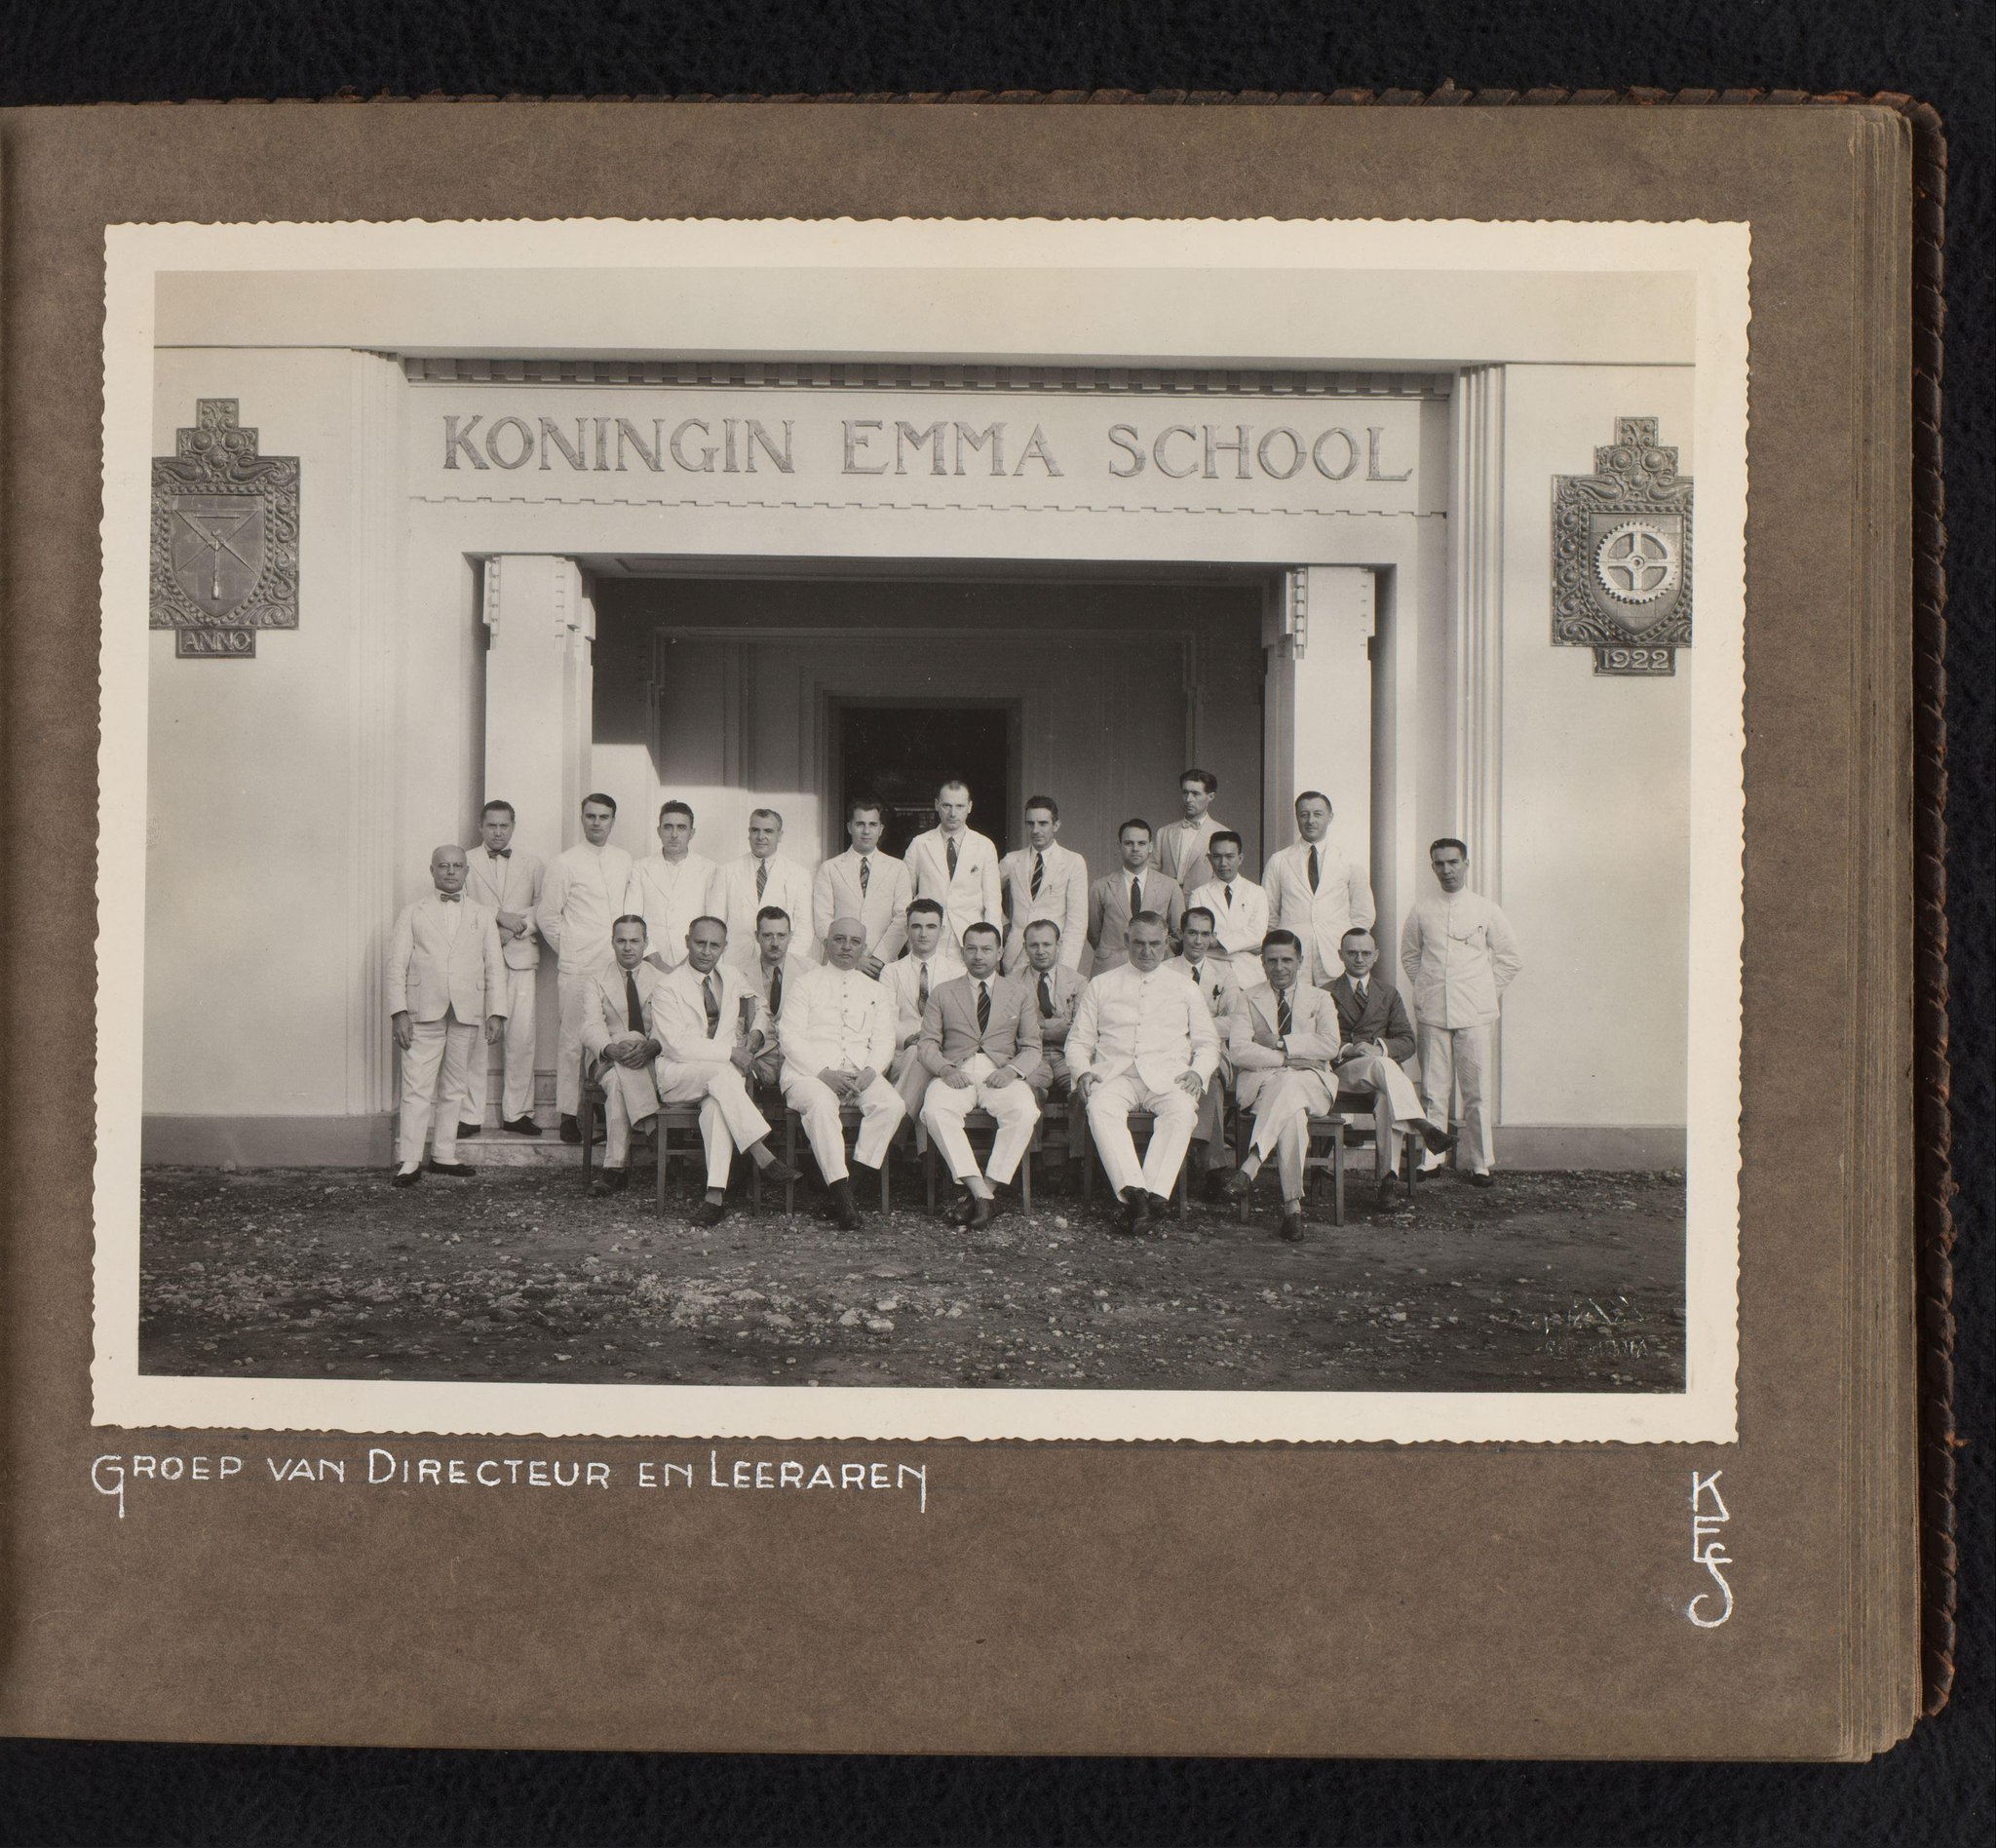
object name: photograph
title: Directeur en leraren van de Koningin Emma School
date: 1933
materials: photographic support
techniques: gelatin silver print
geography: surabaya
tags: vocational education, e.g.: junior technical school, colonial government, dutch east indies, the, surabaya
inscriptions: inscription: ‘Groep van Directeur en Leeraren / KES’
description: Groepsfoto van de directeur en de leraren van de Koningin Emma School te Soerabaja. Groep mannen zittend en staand in enkele rijen voor de ingang van de school. Foto ingeplakt in het fotoalbum aangeboden aan J.H.A. van der Hoeven bij het beëindigen op 31 juli 1933 van zijn diensttijd bij het Nijverheidsonderwijs in Nederlandsch-Indië.